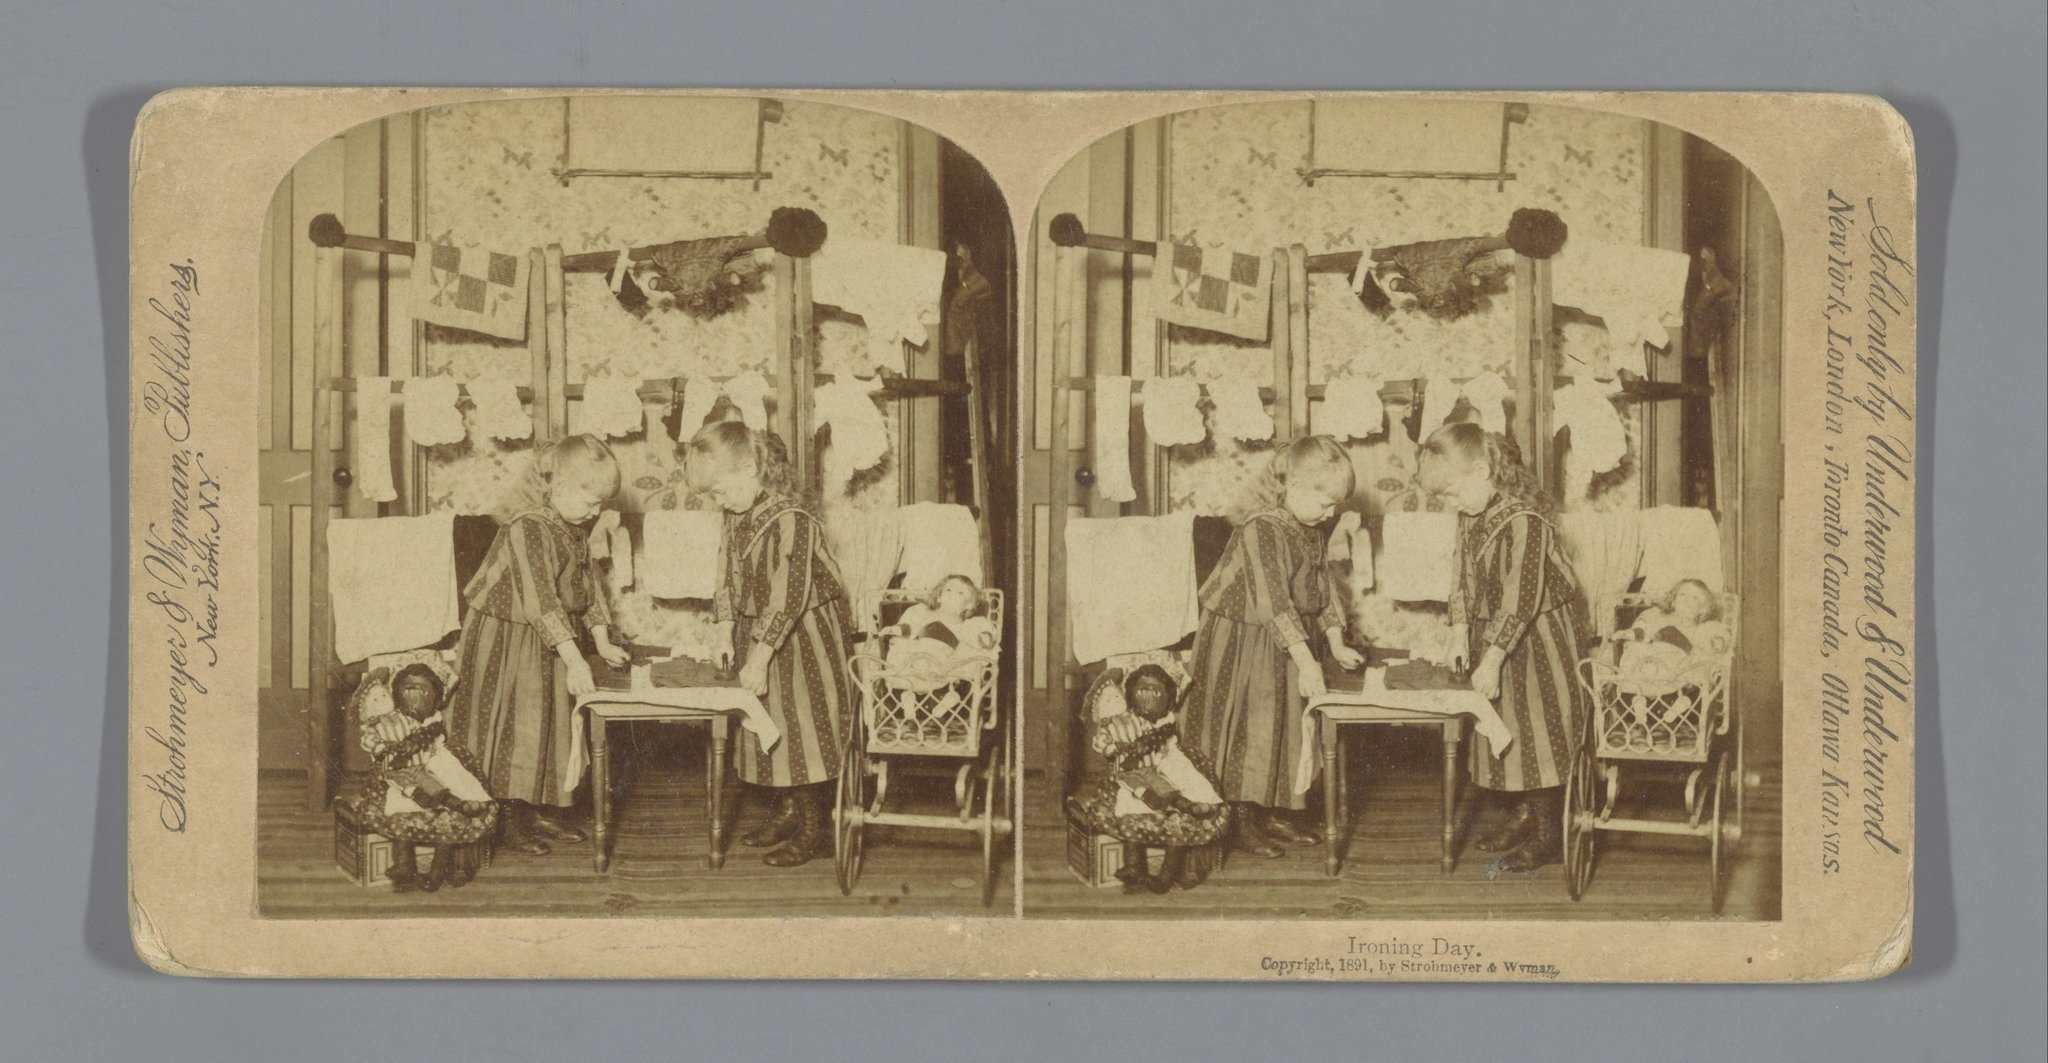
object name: stereograph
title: Poppenkamer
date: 1891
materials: cardboard, photographic support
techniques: albumen print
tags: ironing, (playing with) toys for housekeeping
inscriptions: : ‘Strohmeyer & Wyman Publishers / New York, NY’, : ‘Sold only by Underwood & Underwood / New York, London,Toronto Canada, Ottawa, Kansas’, : ‘Poppenkamer’, : ‘Copyright, 1891, by Strohmeyer & Wyman’